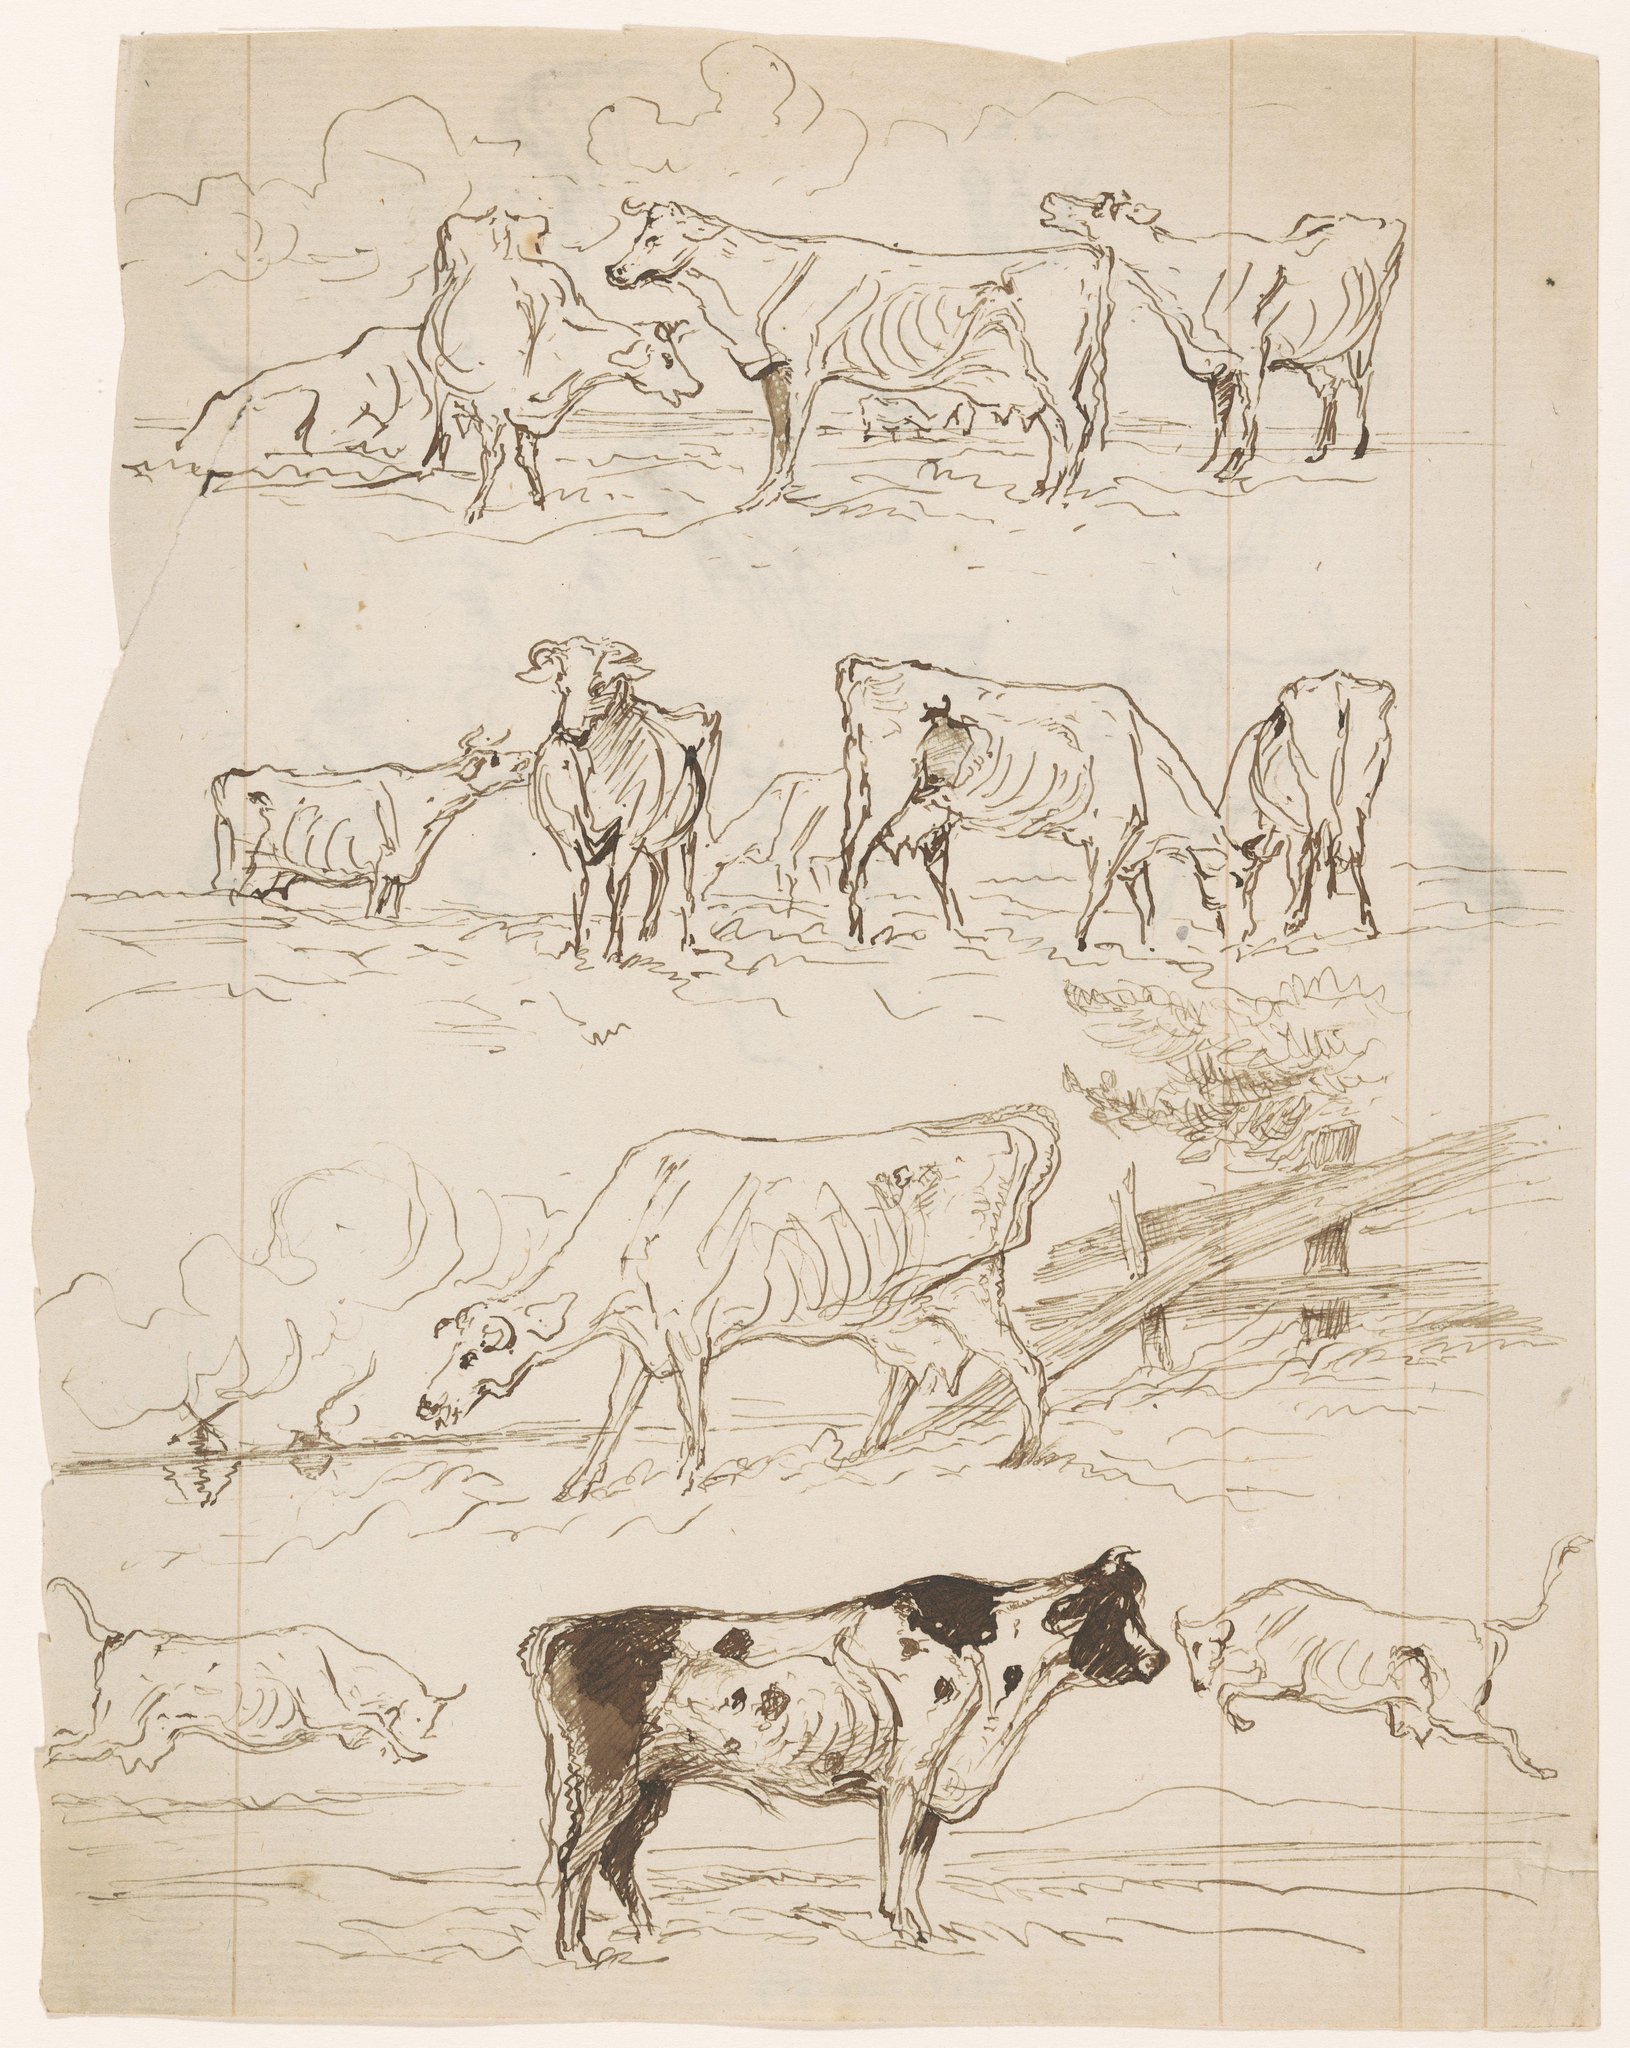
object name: drawing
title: Verschillende schetsen van grazende koeien in de wei en van een stier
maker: johannes tavenraat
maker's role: draughtsman, painter, print maker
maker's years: 1809-1881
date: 1840-1880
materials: ink, paper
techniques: pen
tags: bull, cow, meadow, pasture